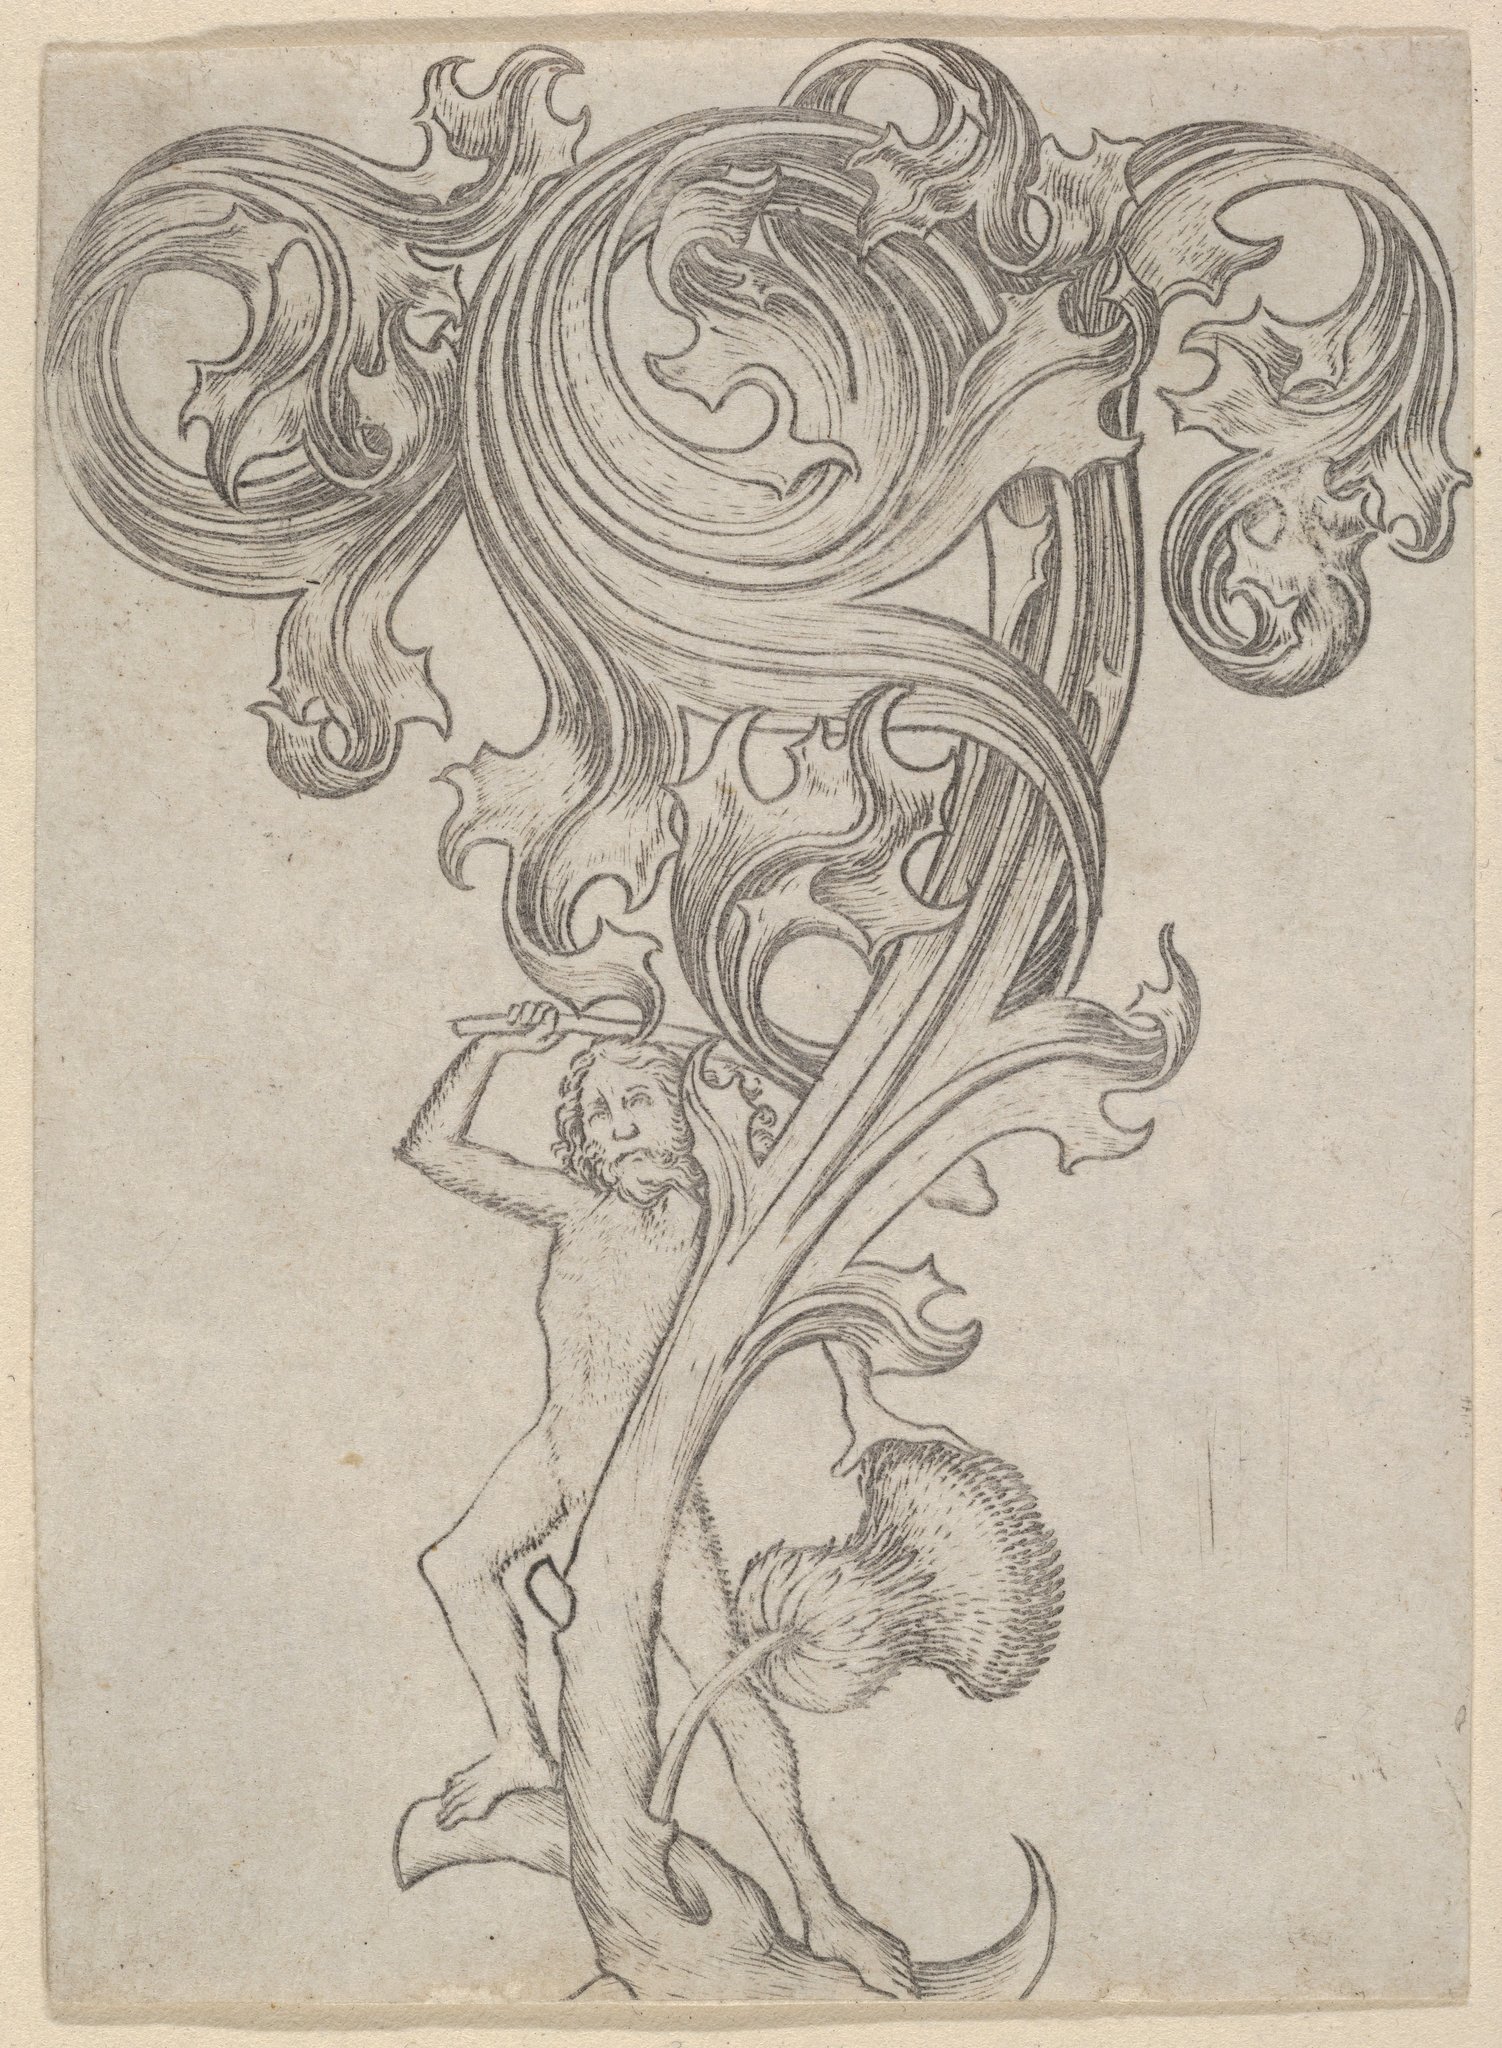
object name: collection ornament architecture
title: Ornament with a Wild Man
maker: master es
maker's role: artist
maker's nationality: german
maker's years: 1445-1467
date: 1401-1500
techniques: engraving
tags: ornament,men,flowers